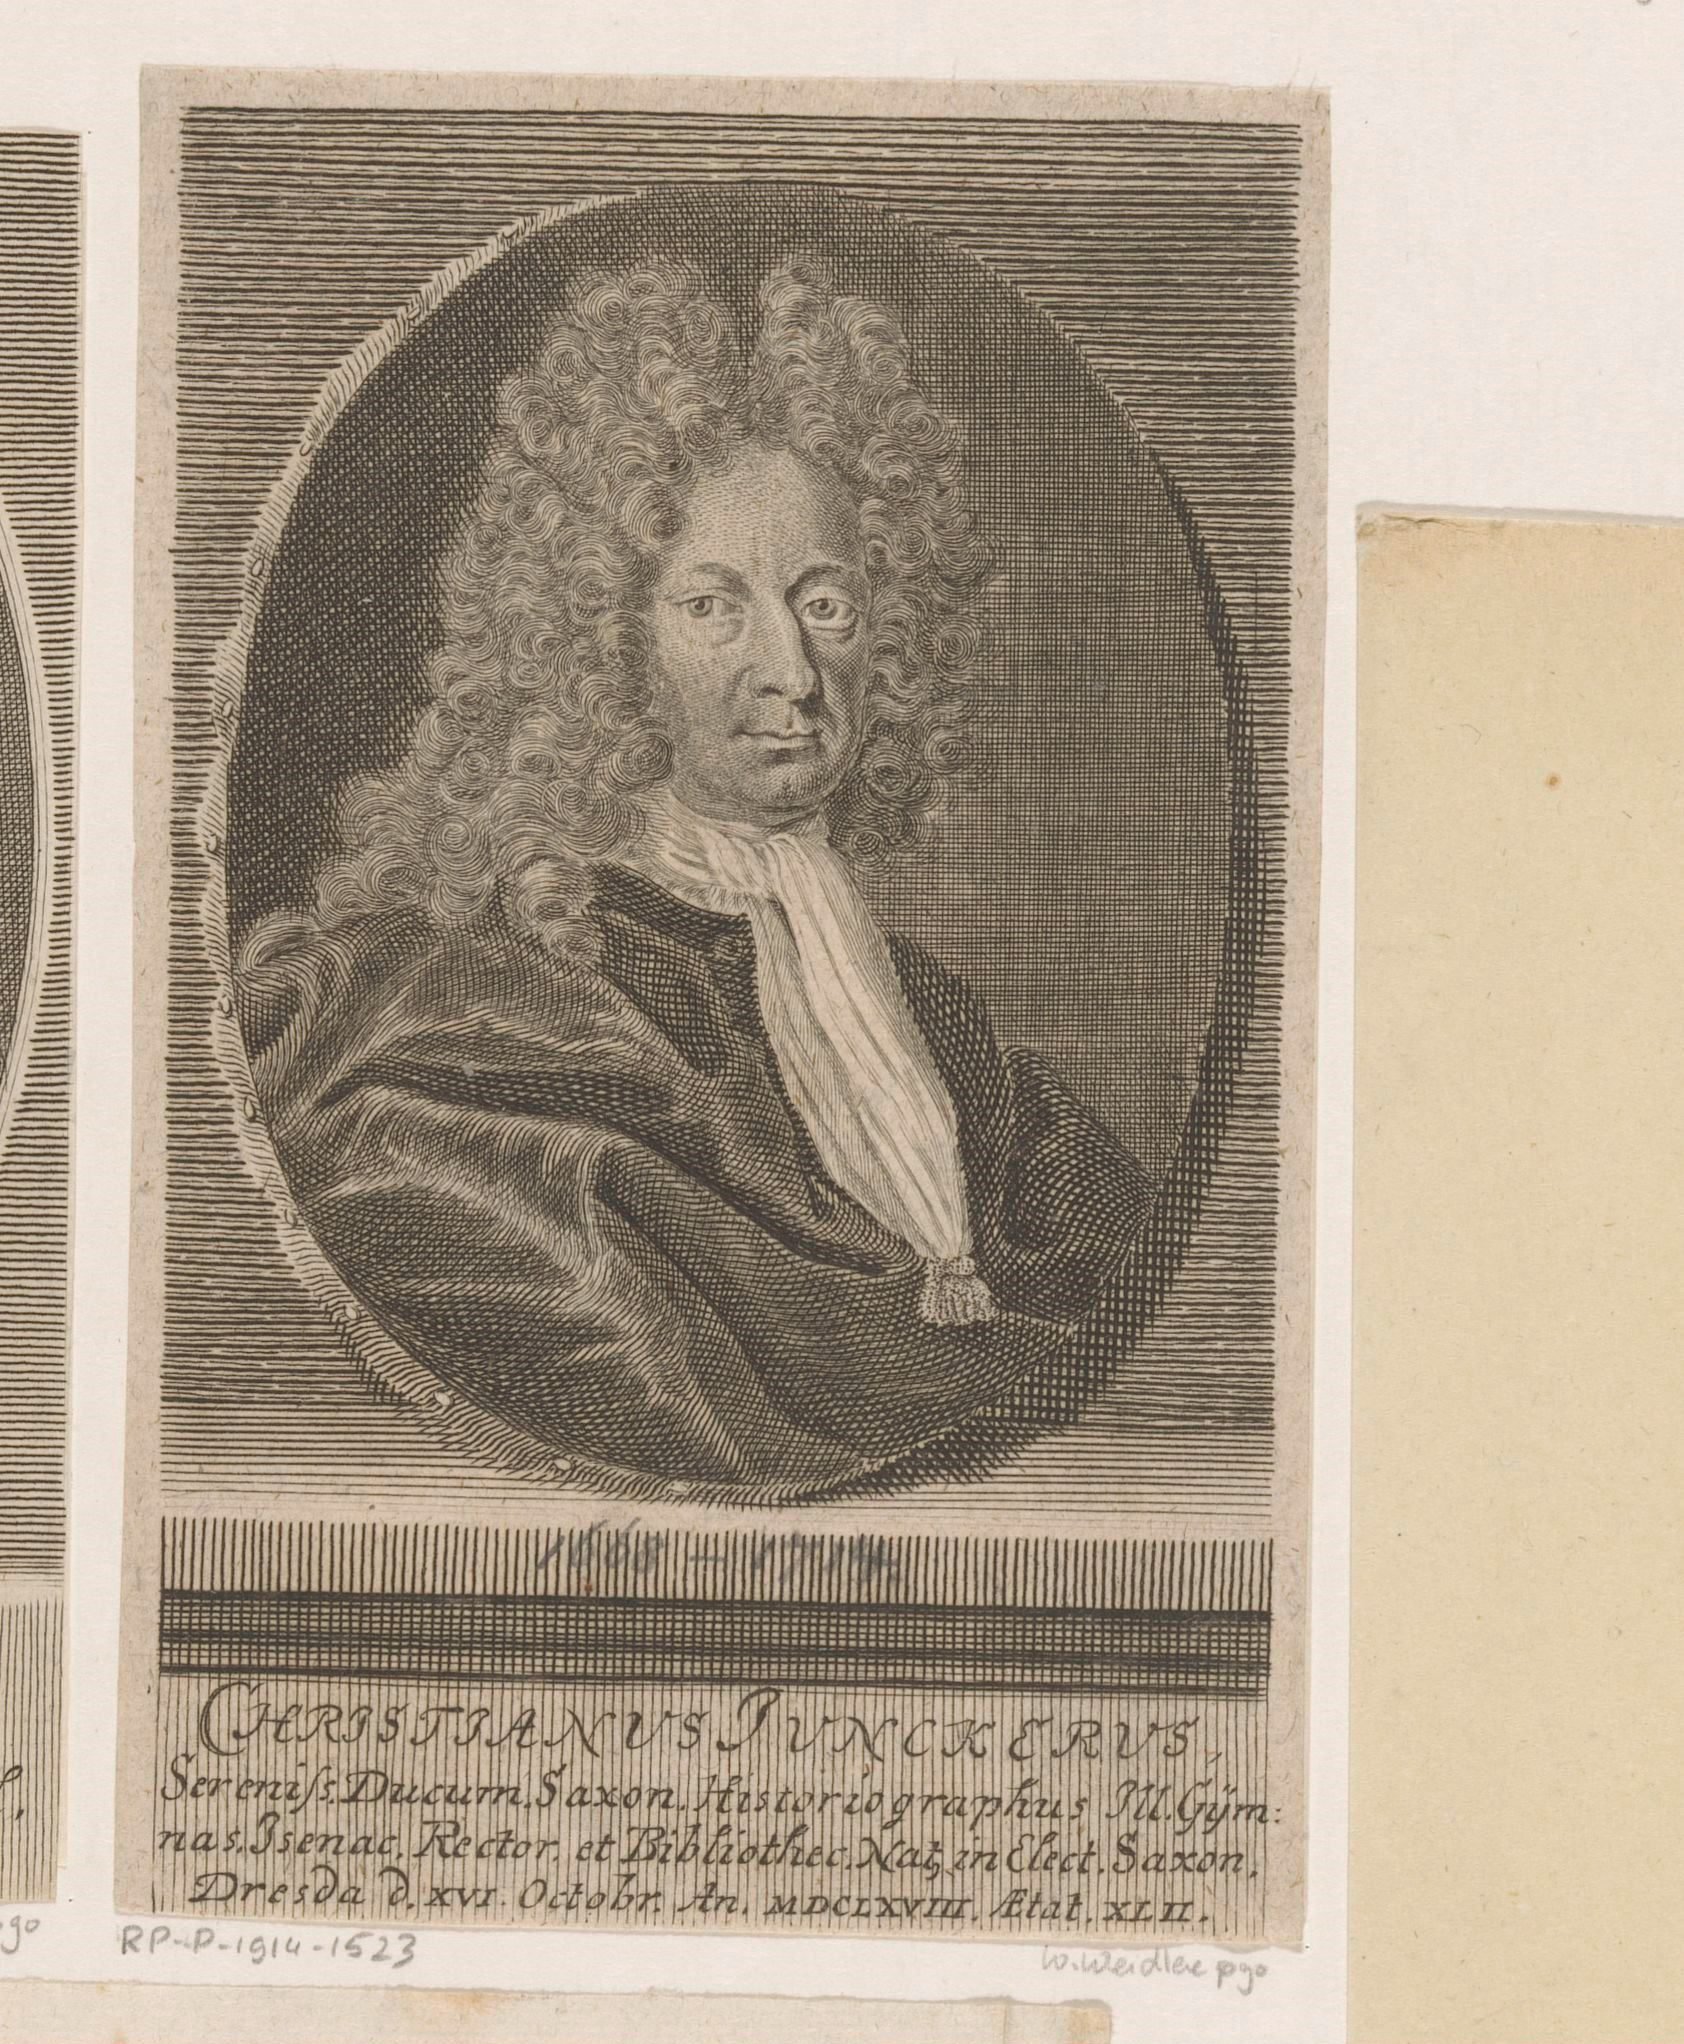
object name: print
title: Portret van Christian Juncker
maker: martin bernigeroth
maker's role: print maker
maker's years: 1670-1733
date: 1710-1733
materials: paper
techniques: engraving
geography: leipzig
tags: historical persons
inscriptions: collector's mark: Lugt 2228